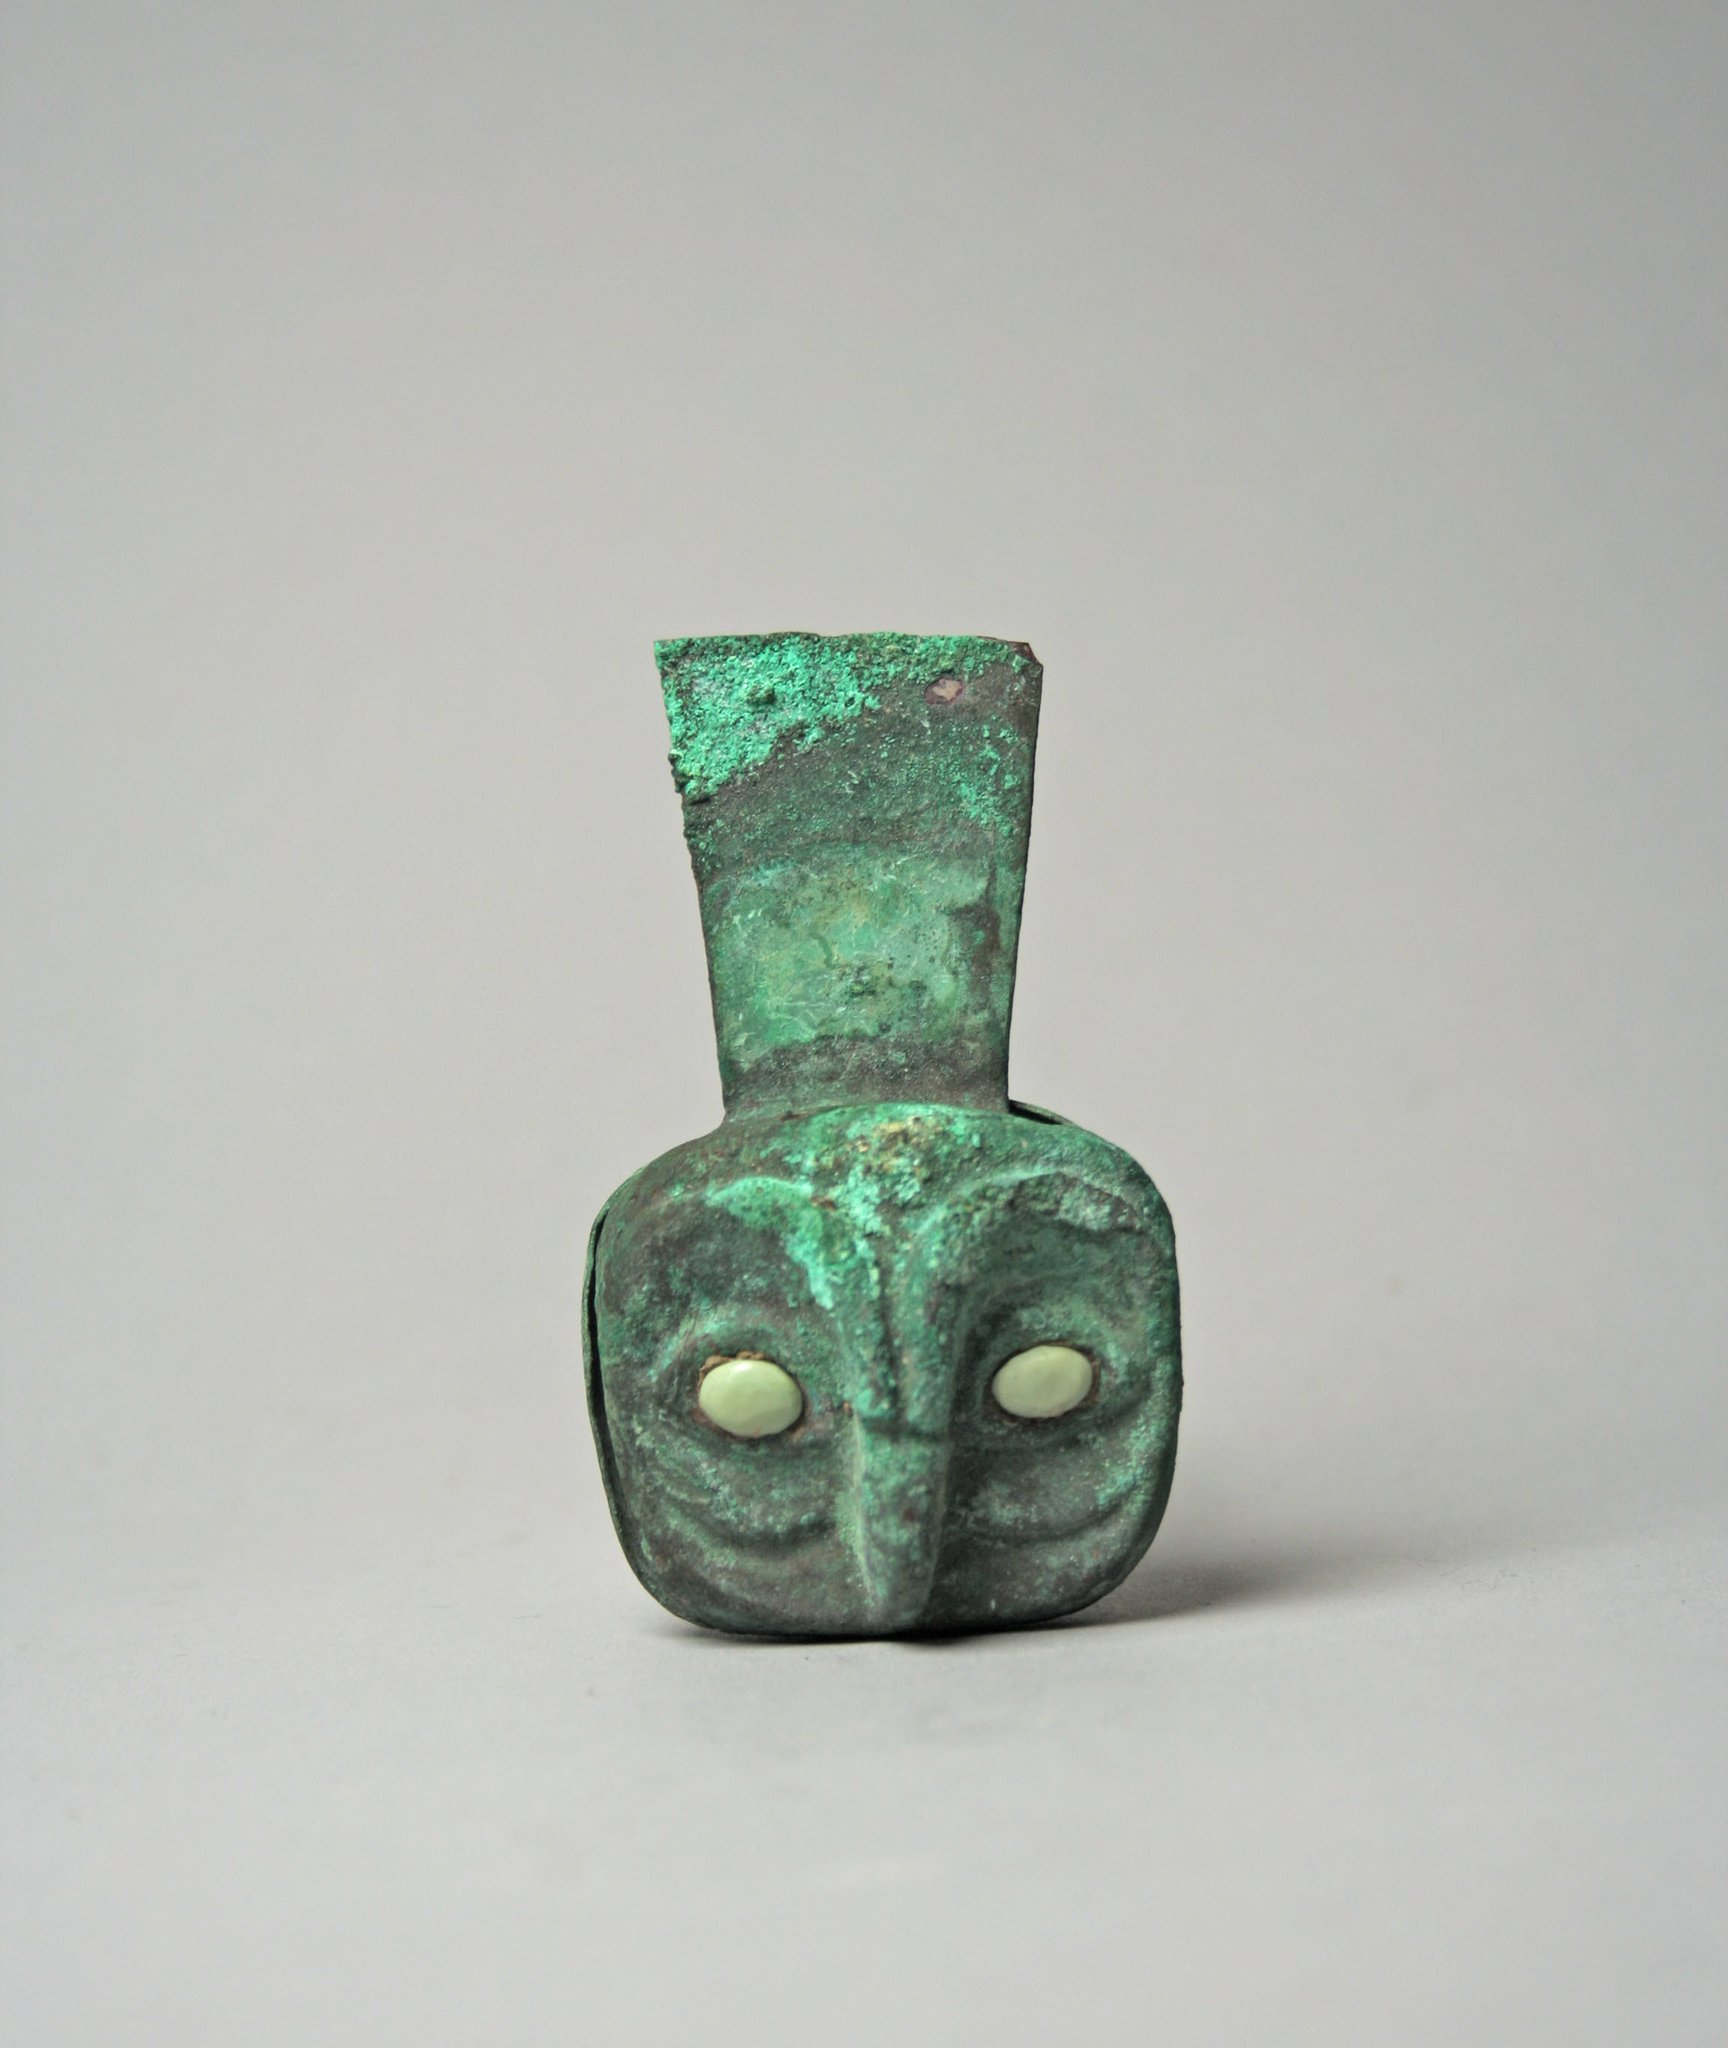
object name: ornament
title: Owl Tab Ornament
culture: moche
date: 501-700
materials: metal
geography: peru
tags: owls